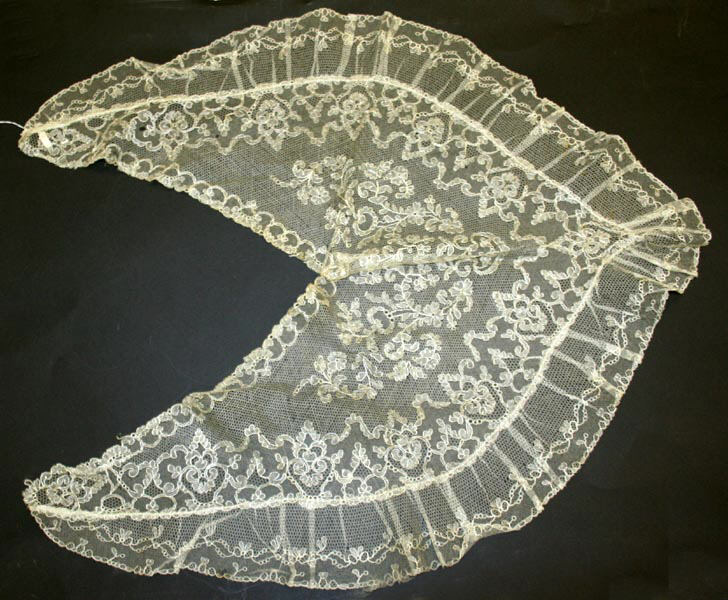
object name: fichu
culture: spanish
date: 1801-1833